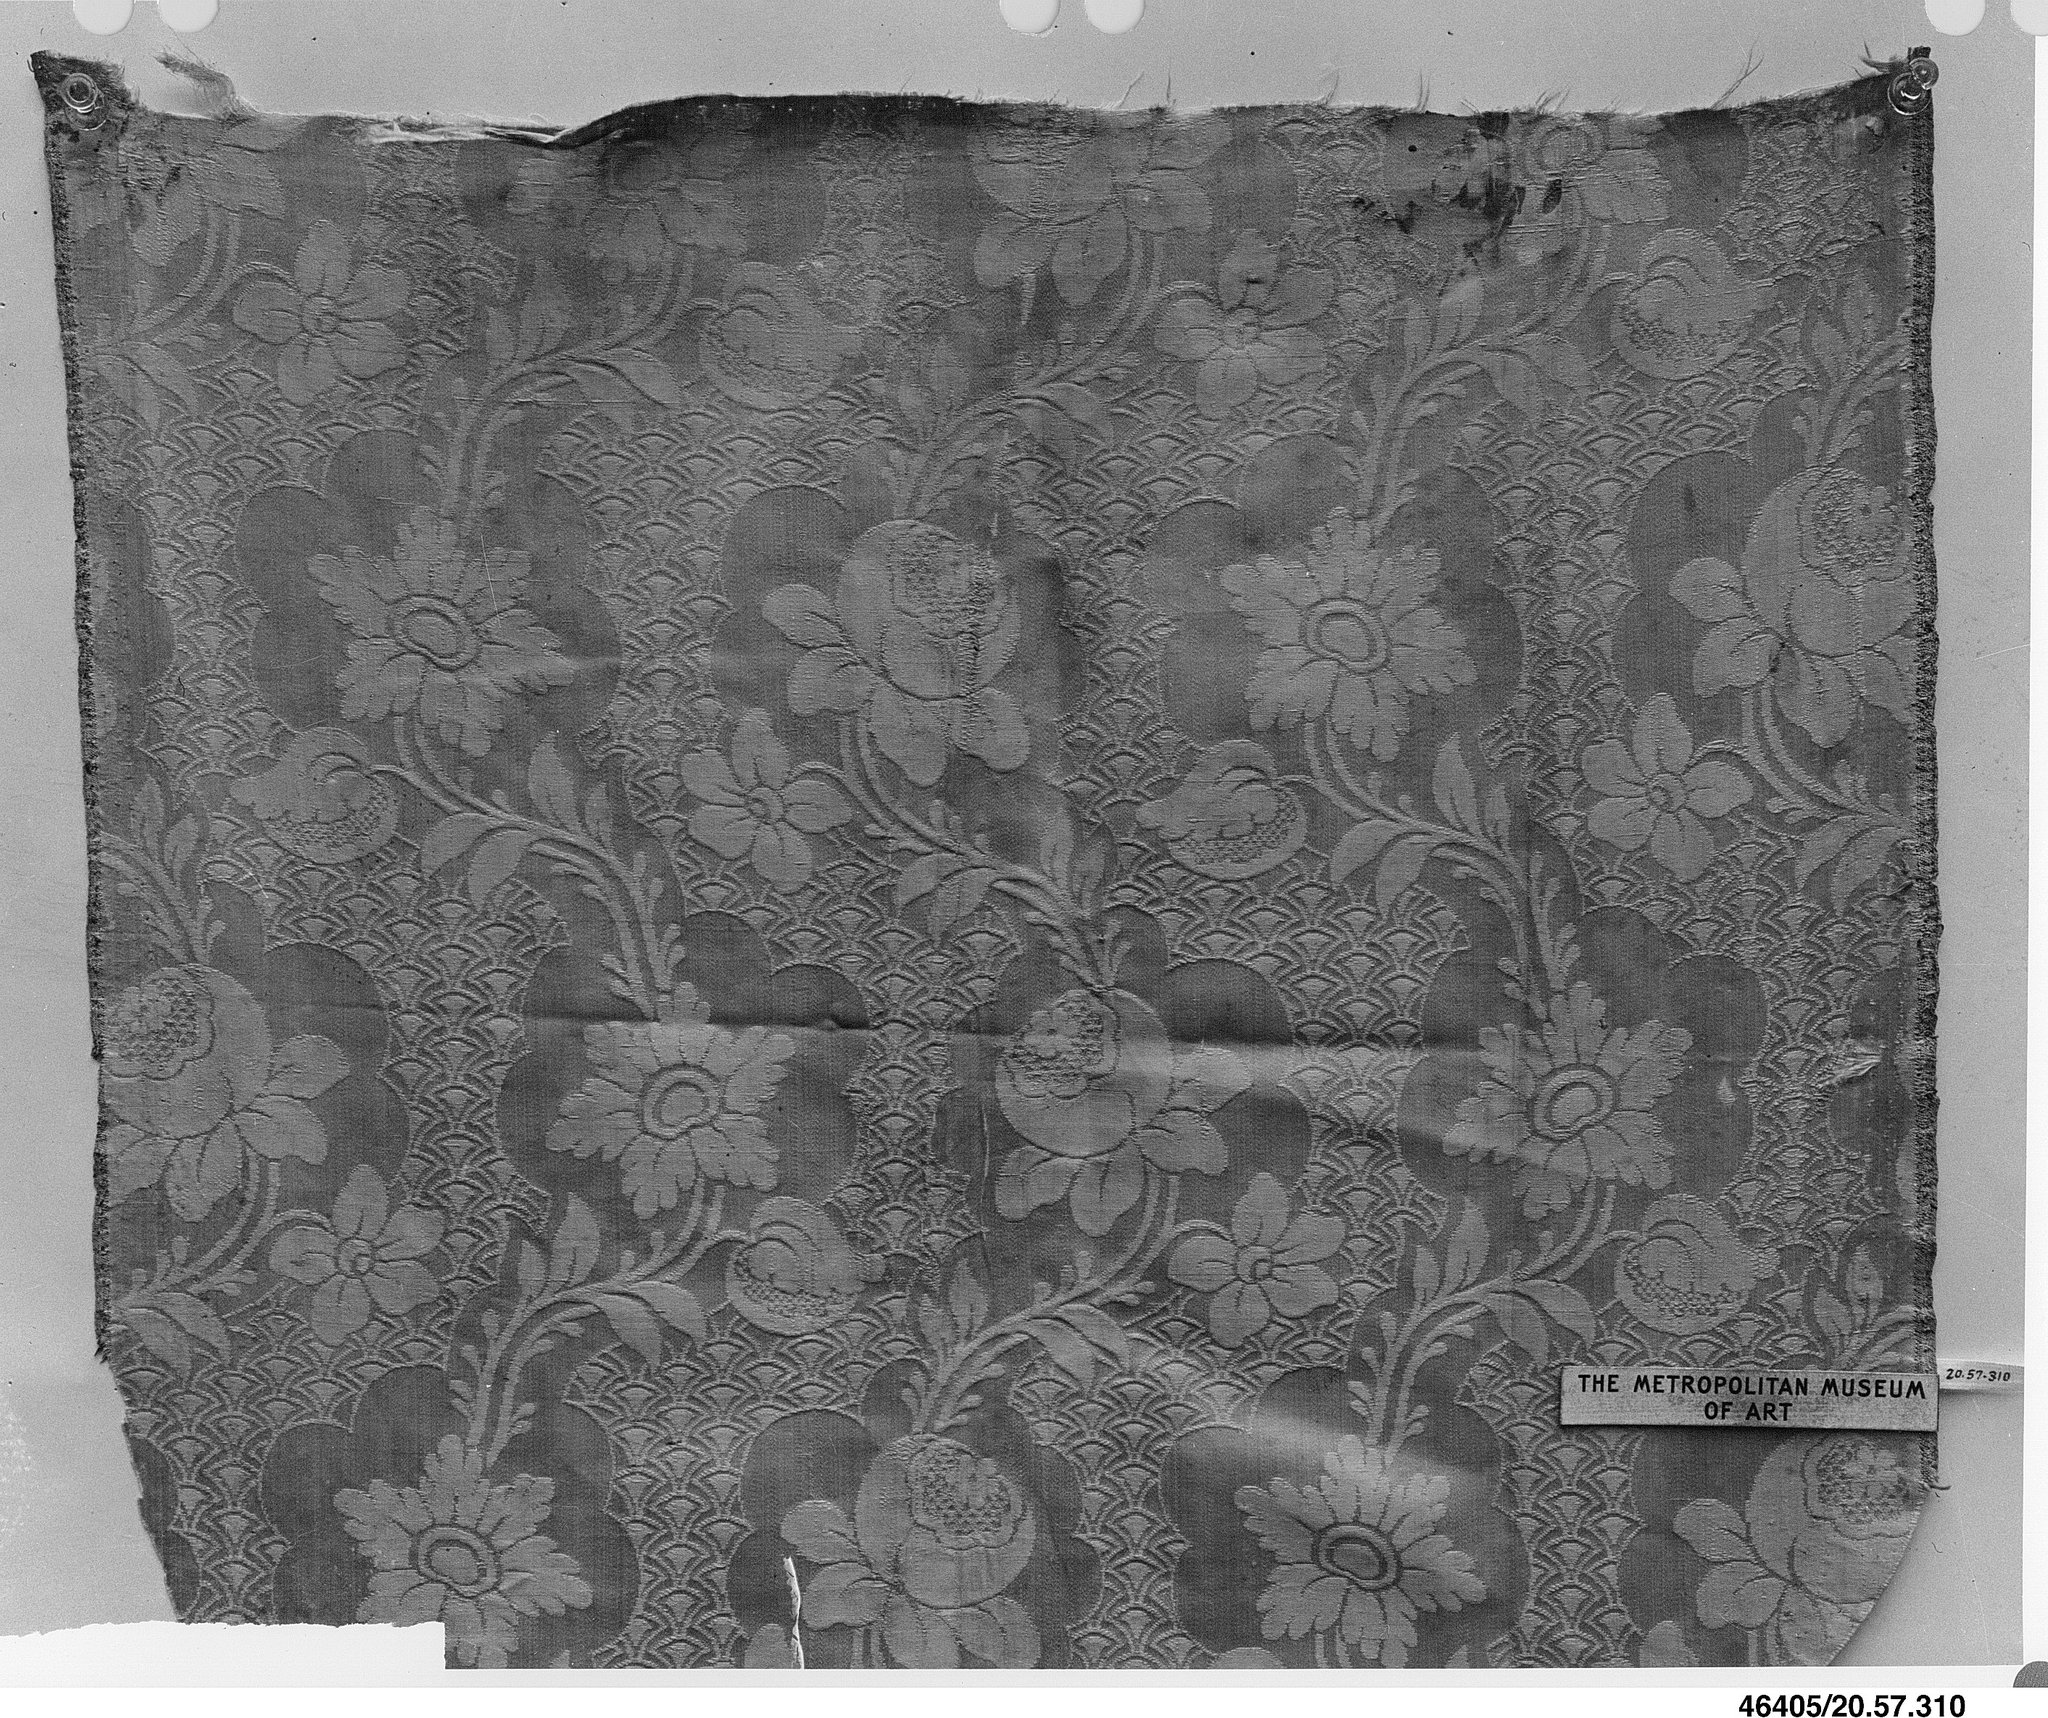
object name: piece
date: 1750-1775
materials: silk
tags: flowers,leaves